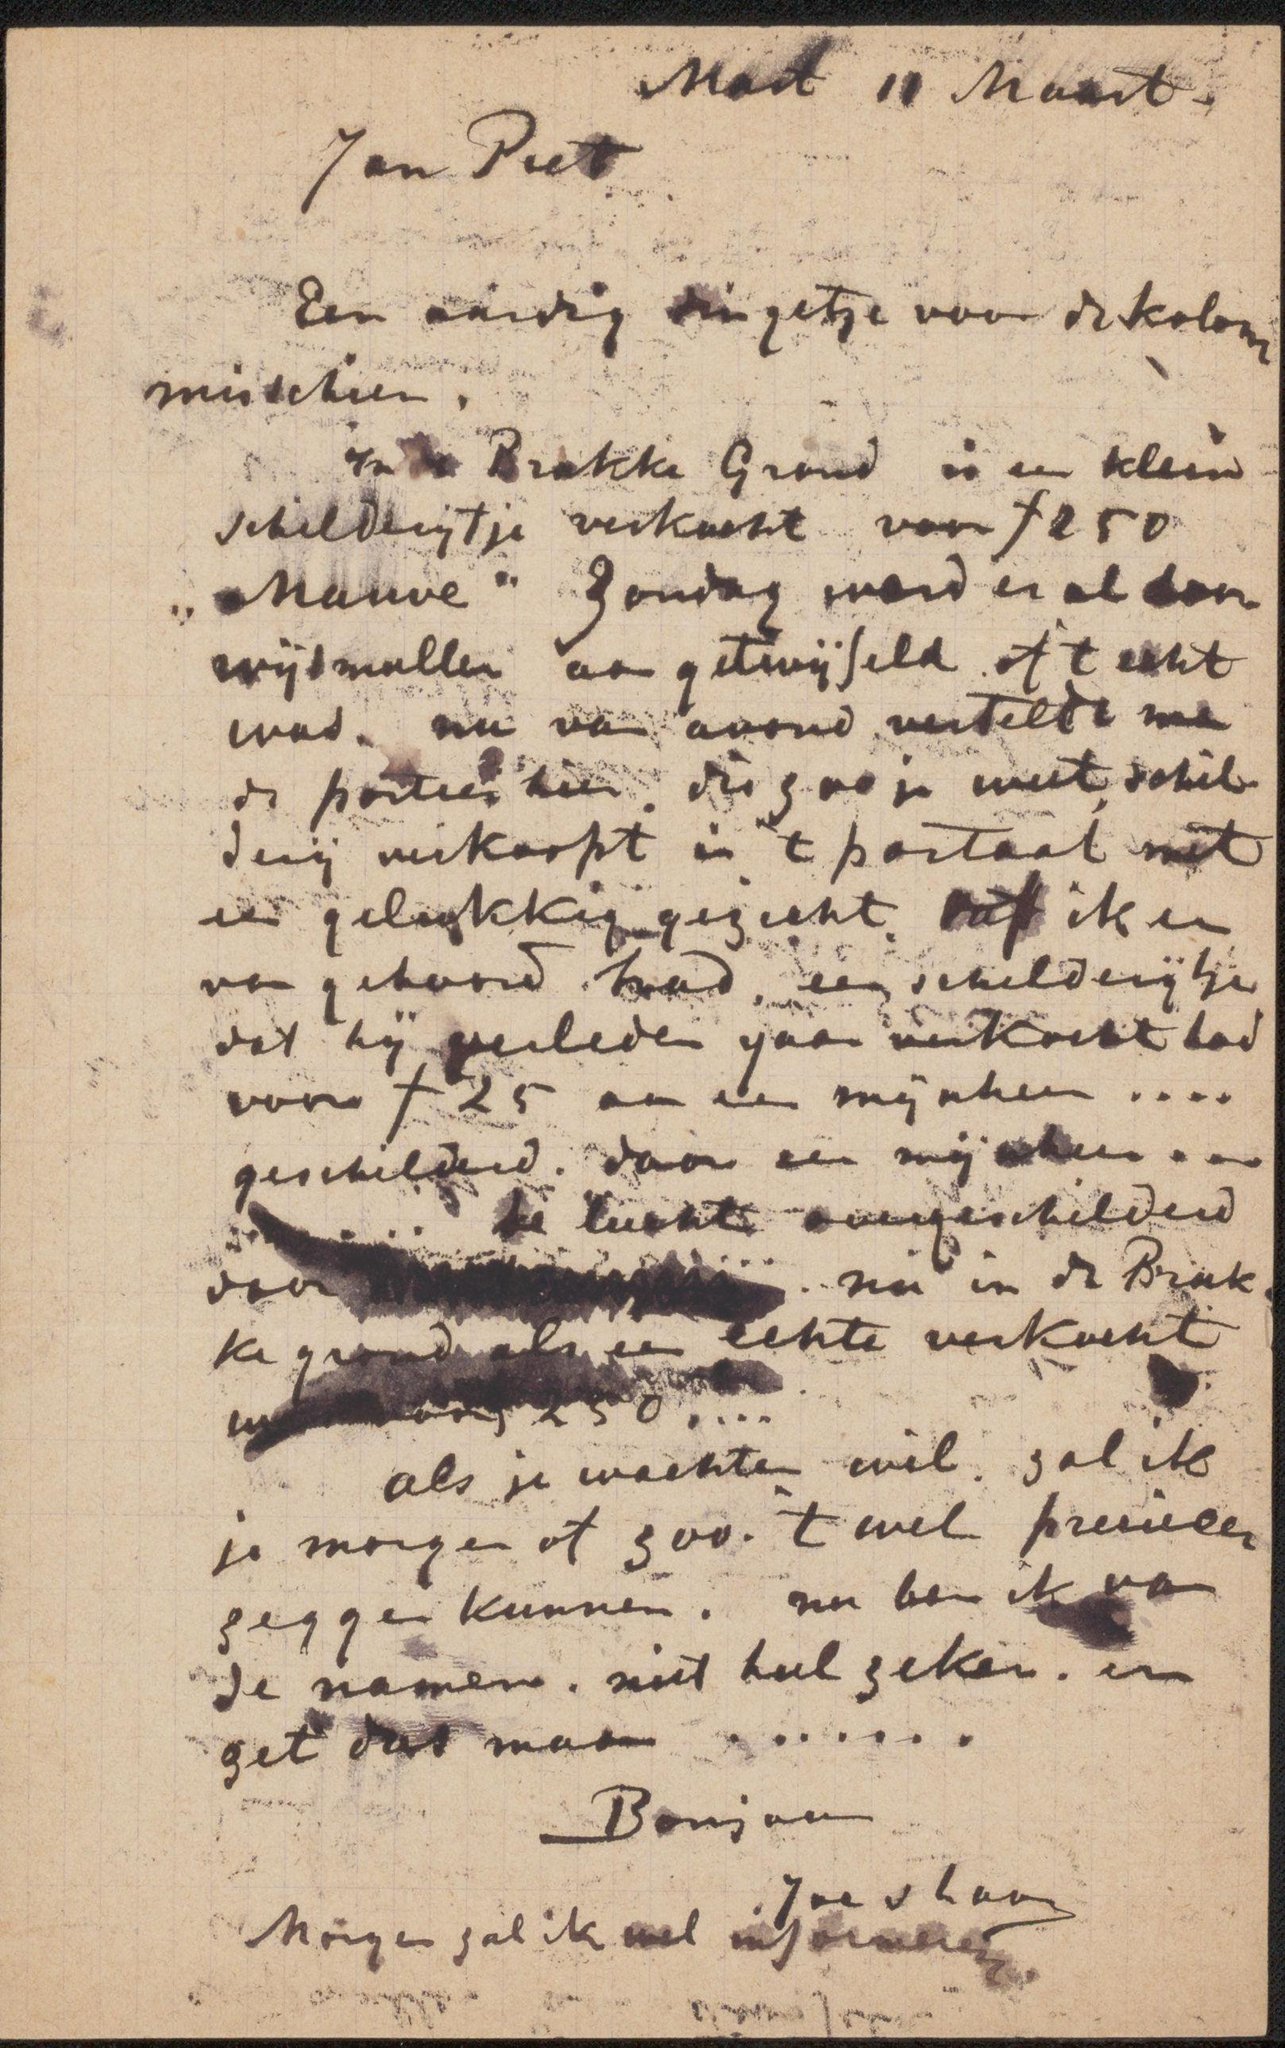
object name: letter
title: Brief aan Jan Veth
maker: jac van looij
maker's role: draughtsman, painter, print maker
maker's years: 1855-1930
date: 1865-1925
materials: ink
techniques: pen, writing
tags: dordrecht, amsterdam, designer, jan veth, arnhem, anton mauve, art trade, art shop, painting (including book-illumination, miniature-painting), money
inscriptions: collector's mark: ‘RPK’